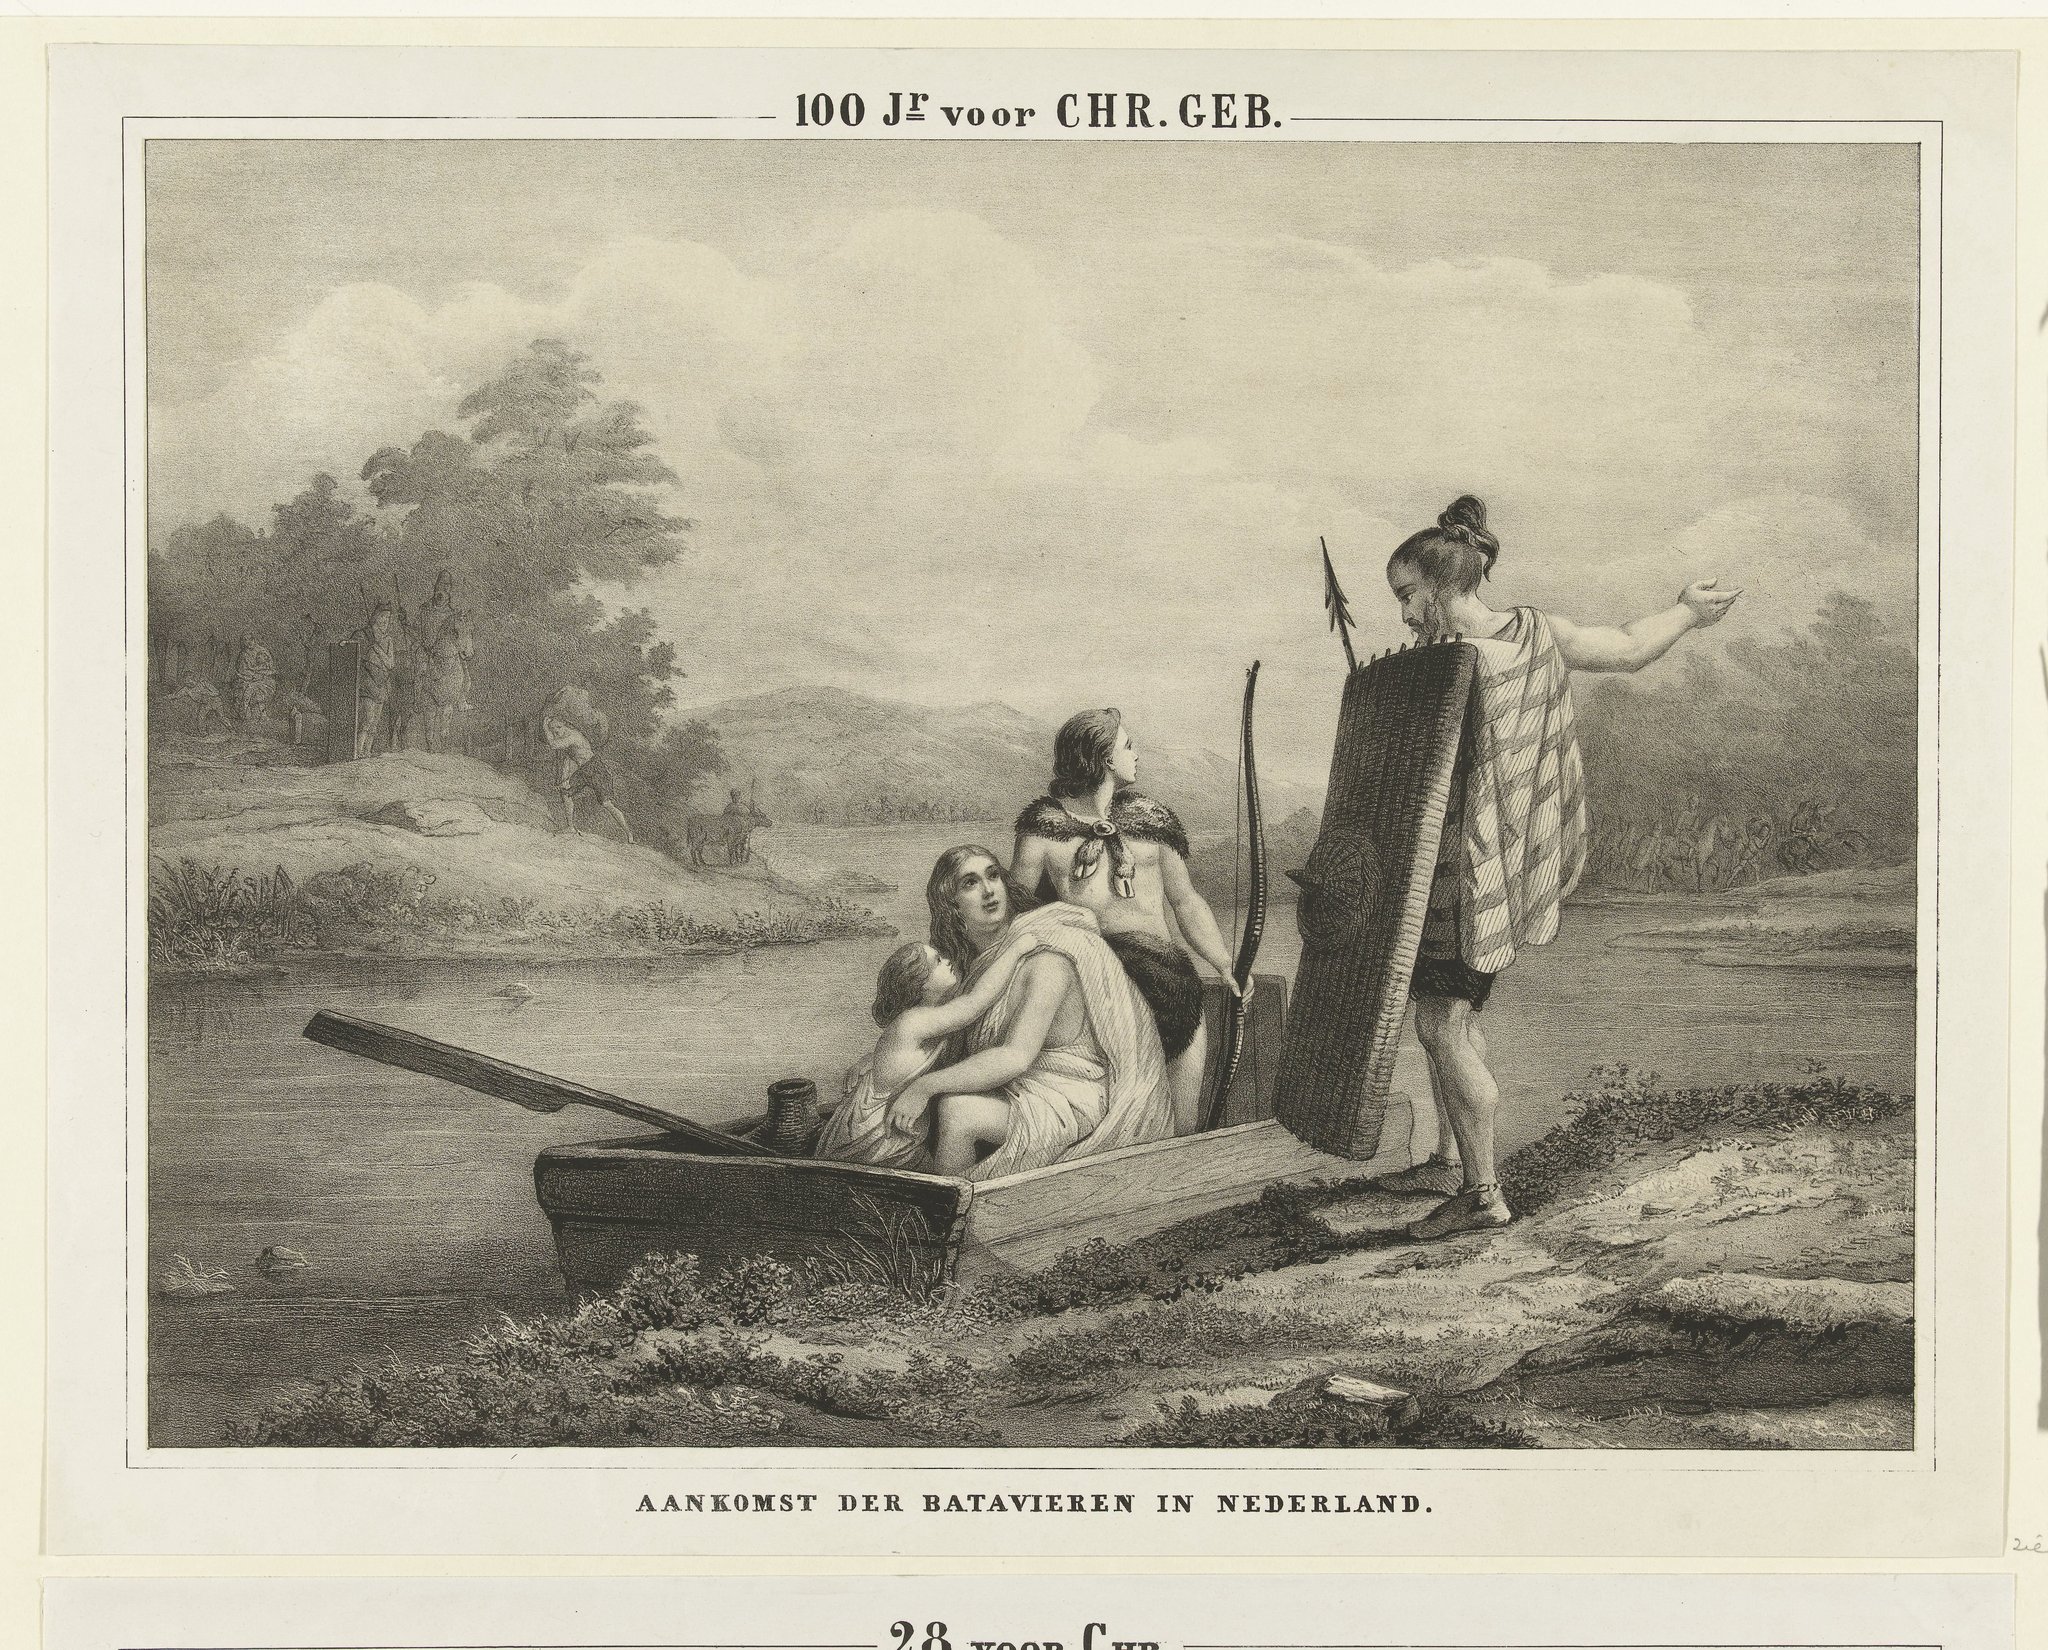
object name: history print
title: 100 Jr voor Chr. Geb. / Aankomst der Batavieren in Nederland, eerste eeuw v.C.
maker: tieleman cato bruining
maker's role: print maker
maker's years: 1801-1877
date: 1850-1855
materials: paper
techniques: lithograph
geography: netherlands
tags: extinct, 'historical' peoples (with name), netherlands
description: Illustratie voor: J.H. Eichman & H. Altmann, Vaderlandsche historieplaten voor scholen en huisgezinnen, Leiden, 1855. Dit nummer is een door het RPK toegevoegd nummer en staat niet in Frederik Muller, het werk waar de prent voor is gemaakt of uit afkomstig is, staat wel vermeld in Frederik Muller.